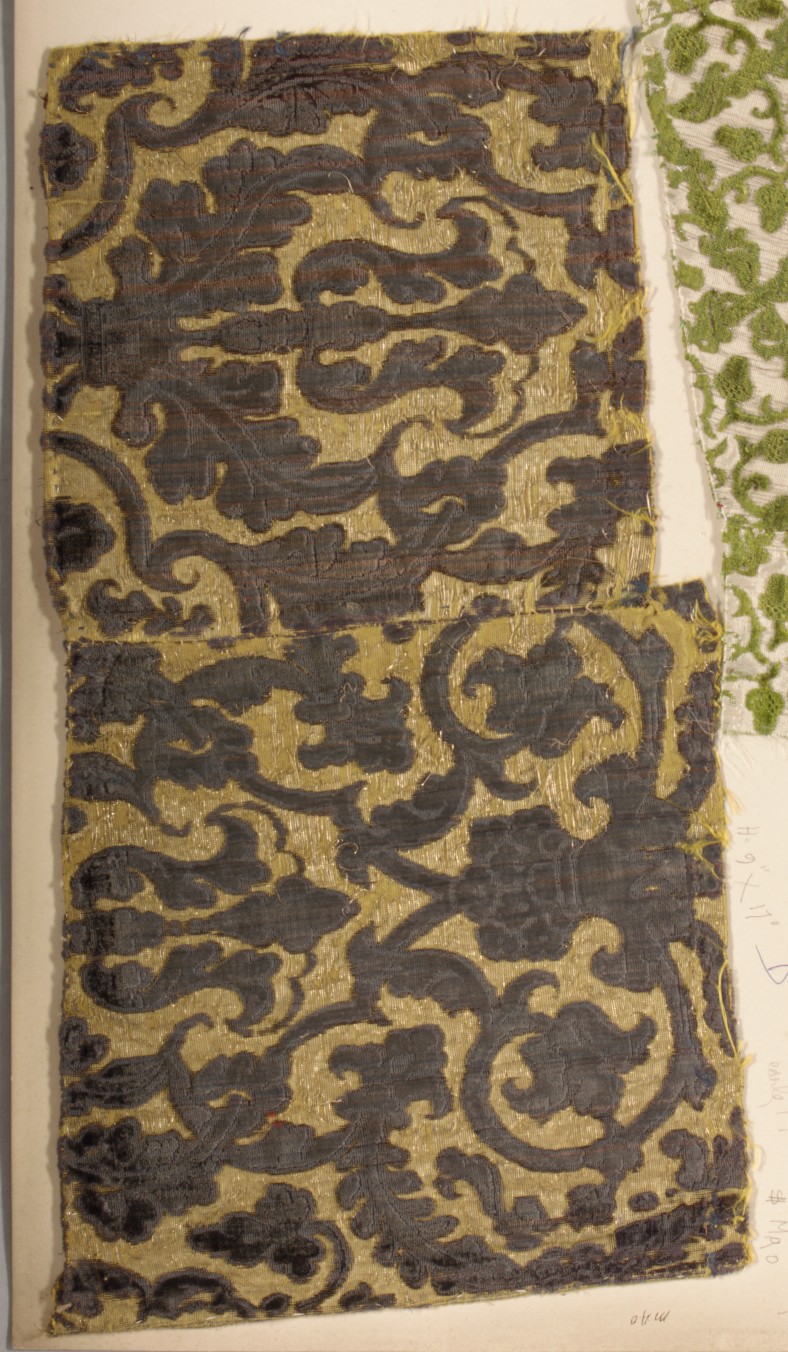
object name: fragment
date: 1601-1633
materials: metal thread, silk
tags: flowers,leaves